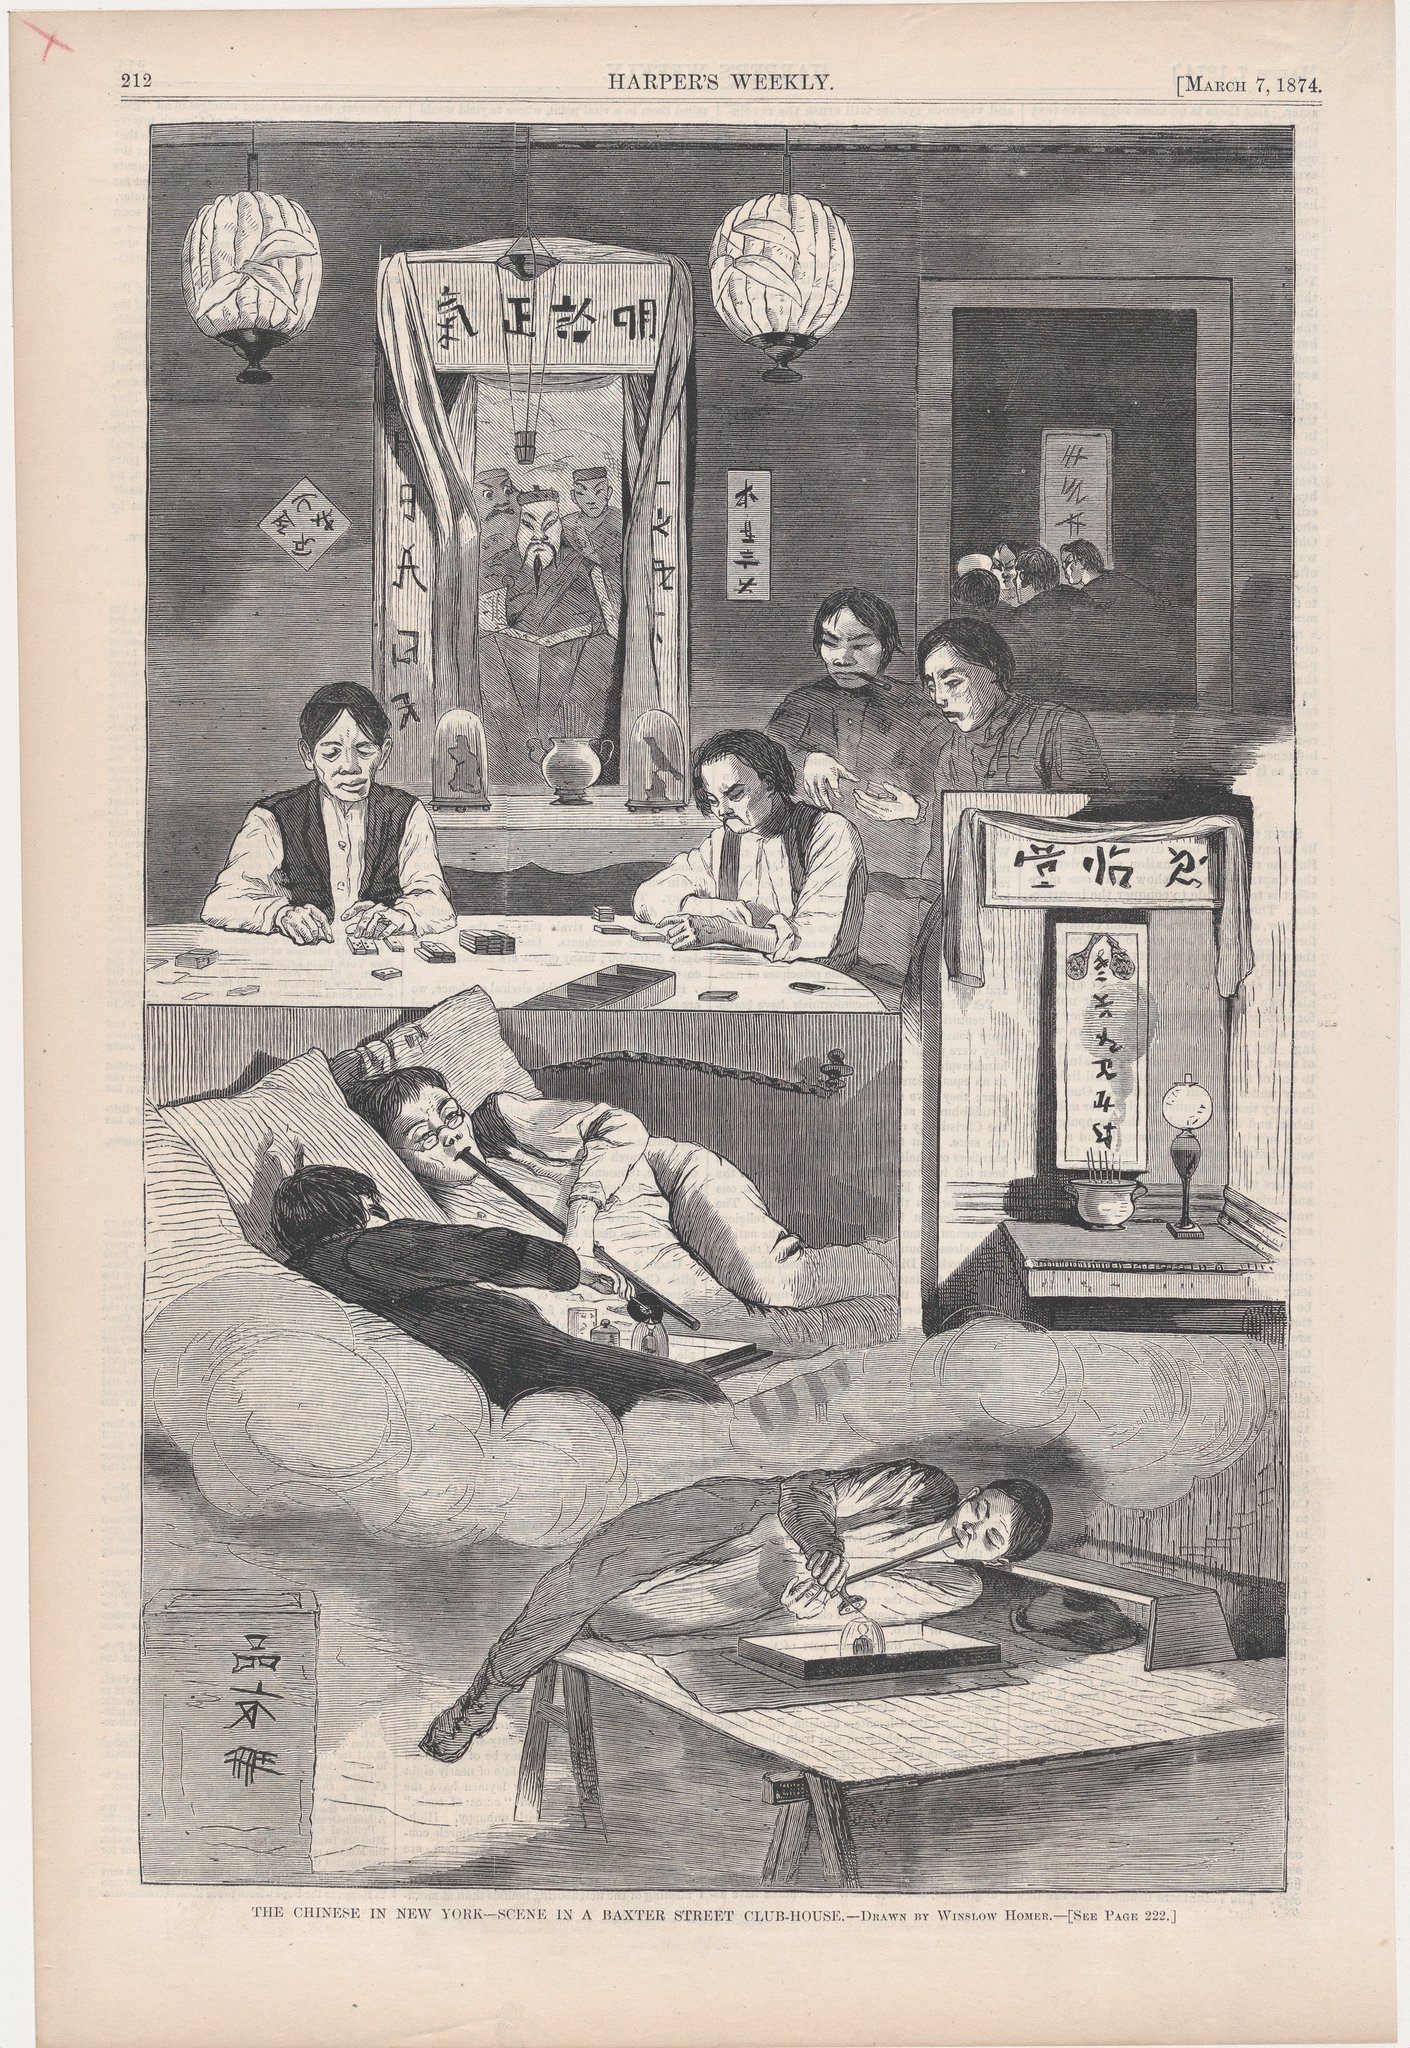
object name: print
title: The Chinese in New York – Scene in a Baxter Street Club-House (from "Harper's Weekly," Vol. XVIII)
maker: winslow homer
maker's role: artist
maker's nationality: american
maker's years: 1836-1910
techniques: engraving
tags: interiors,men,smoking,pipes